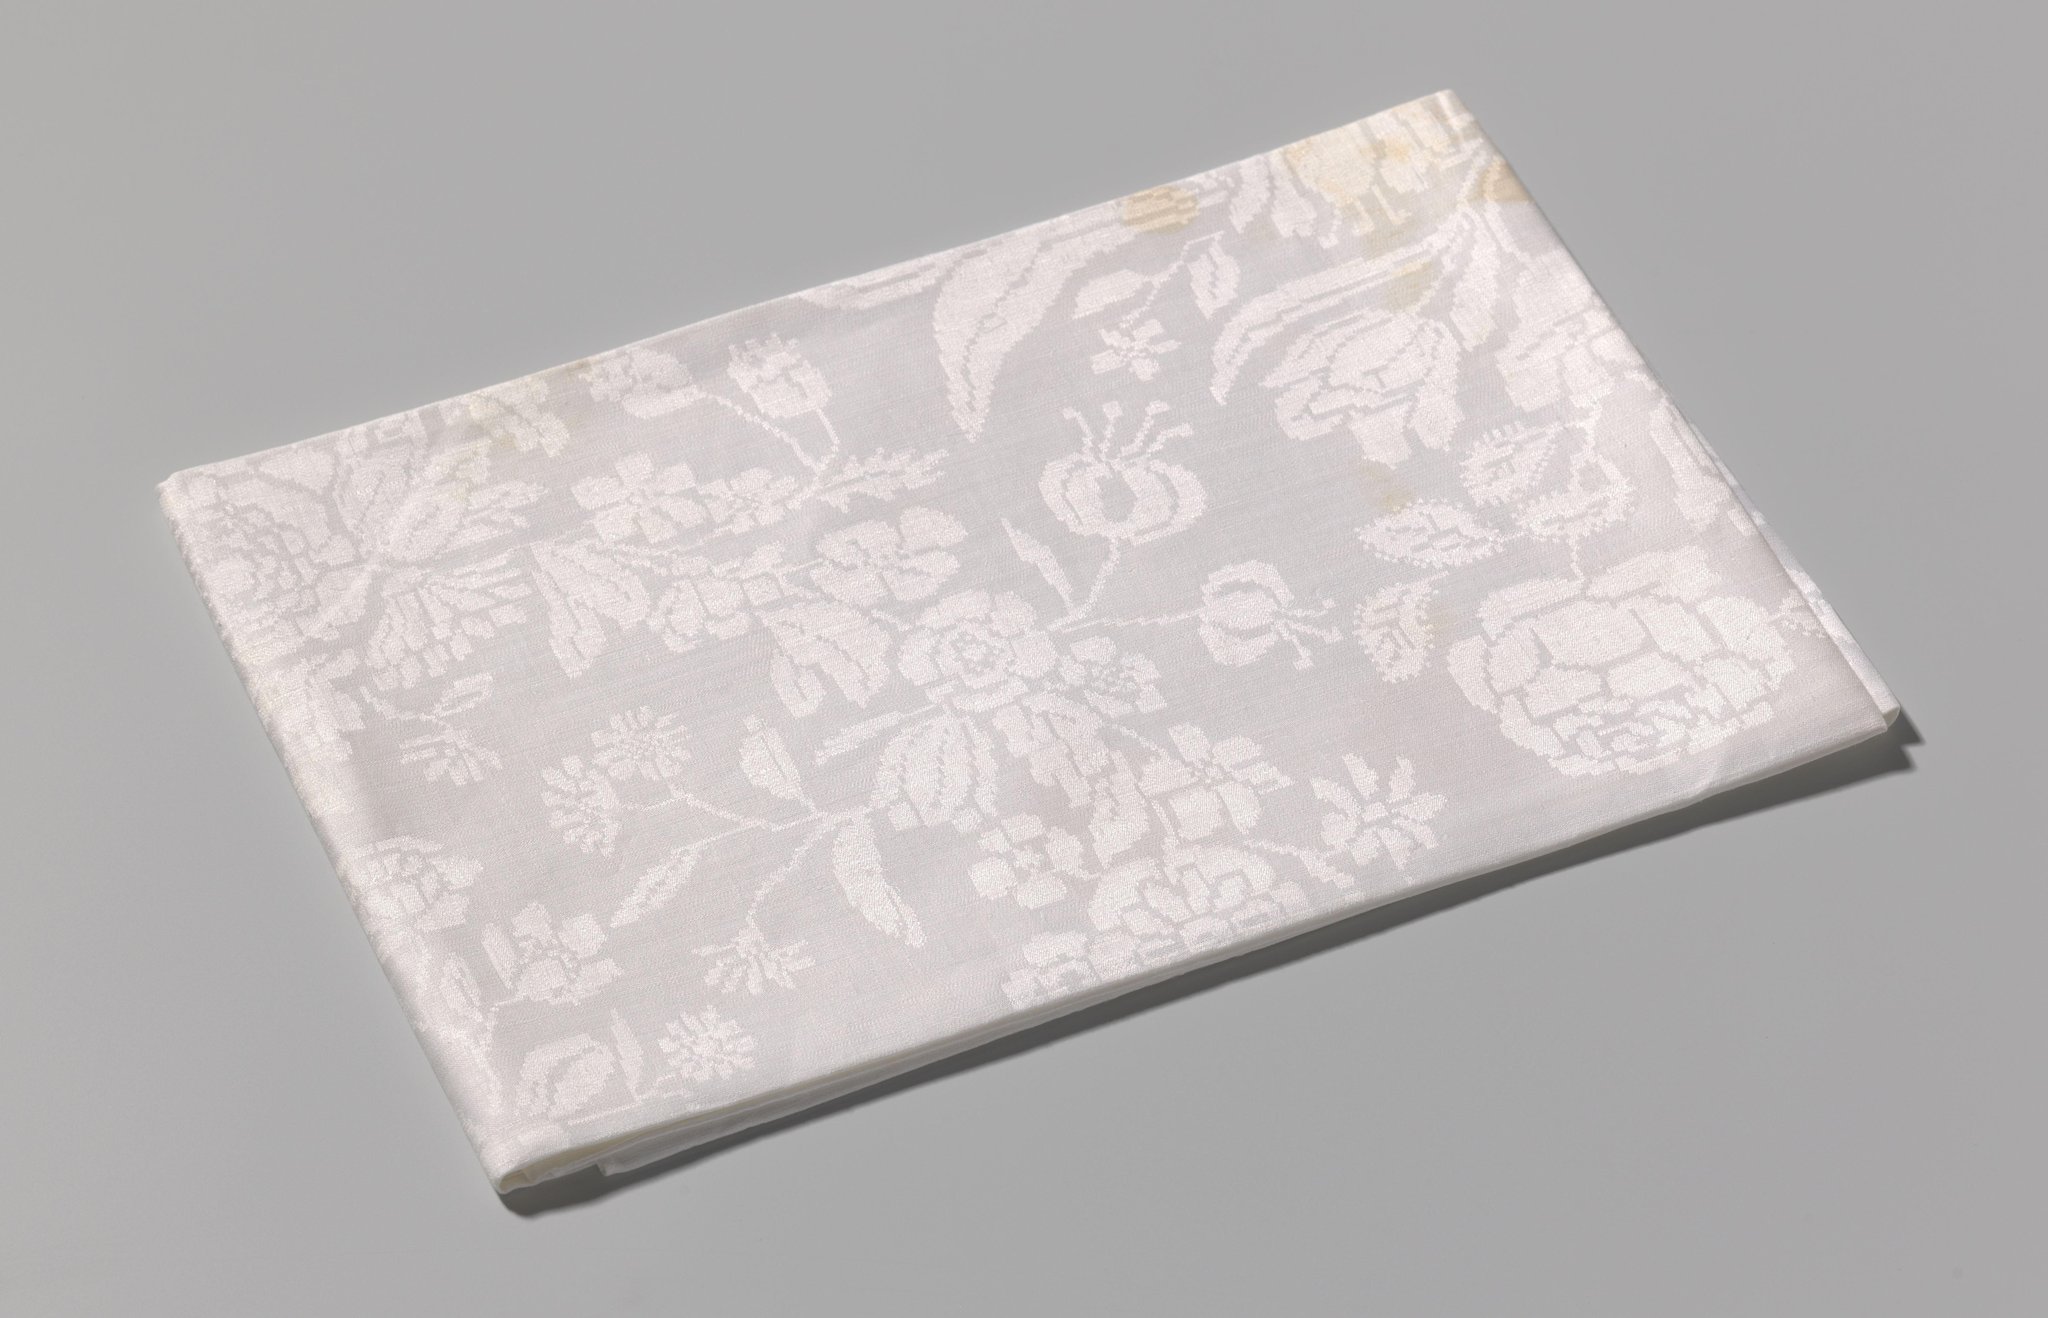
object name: napkin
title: Servet van wit linnendamast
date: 1680-1690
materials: linen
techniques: damask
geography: northern netherlands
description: Wit linnendamasten servet met een patroon van bloemenkransen en ruikers.